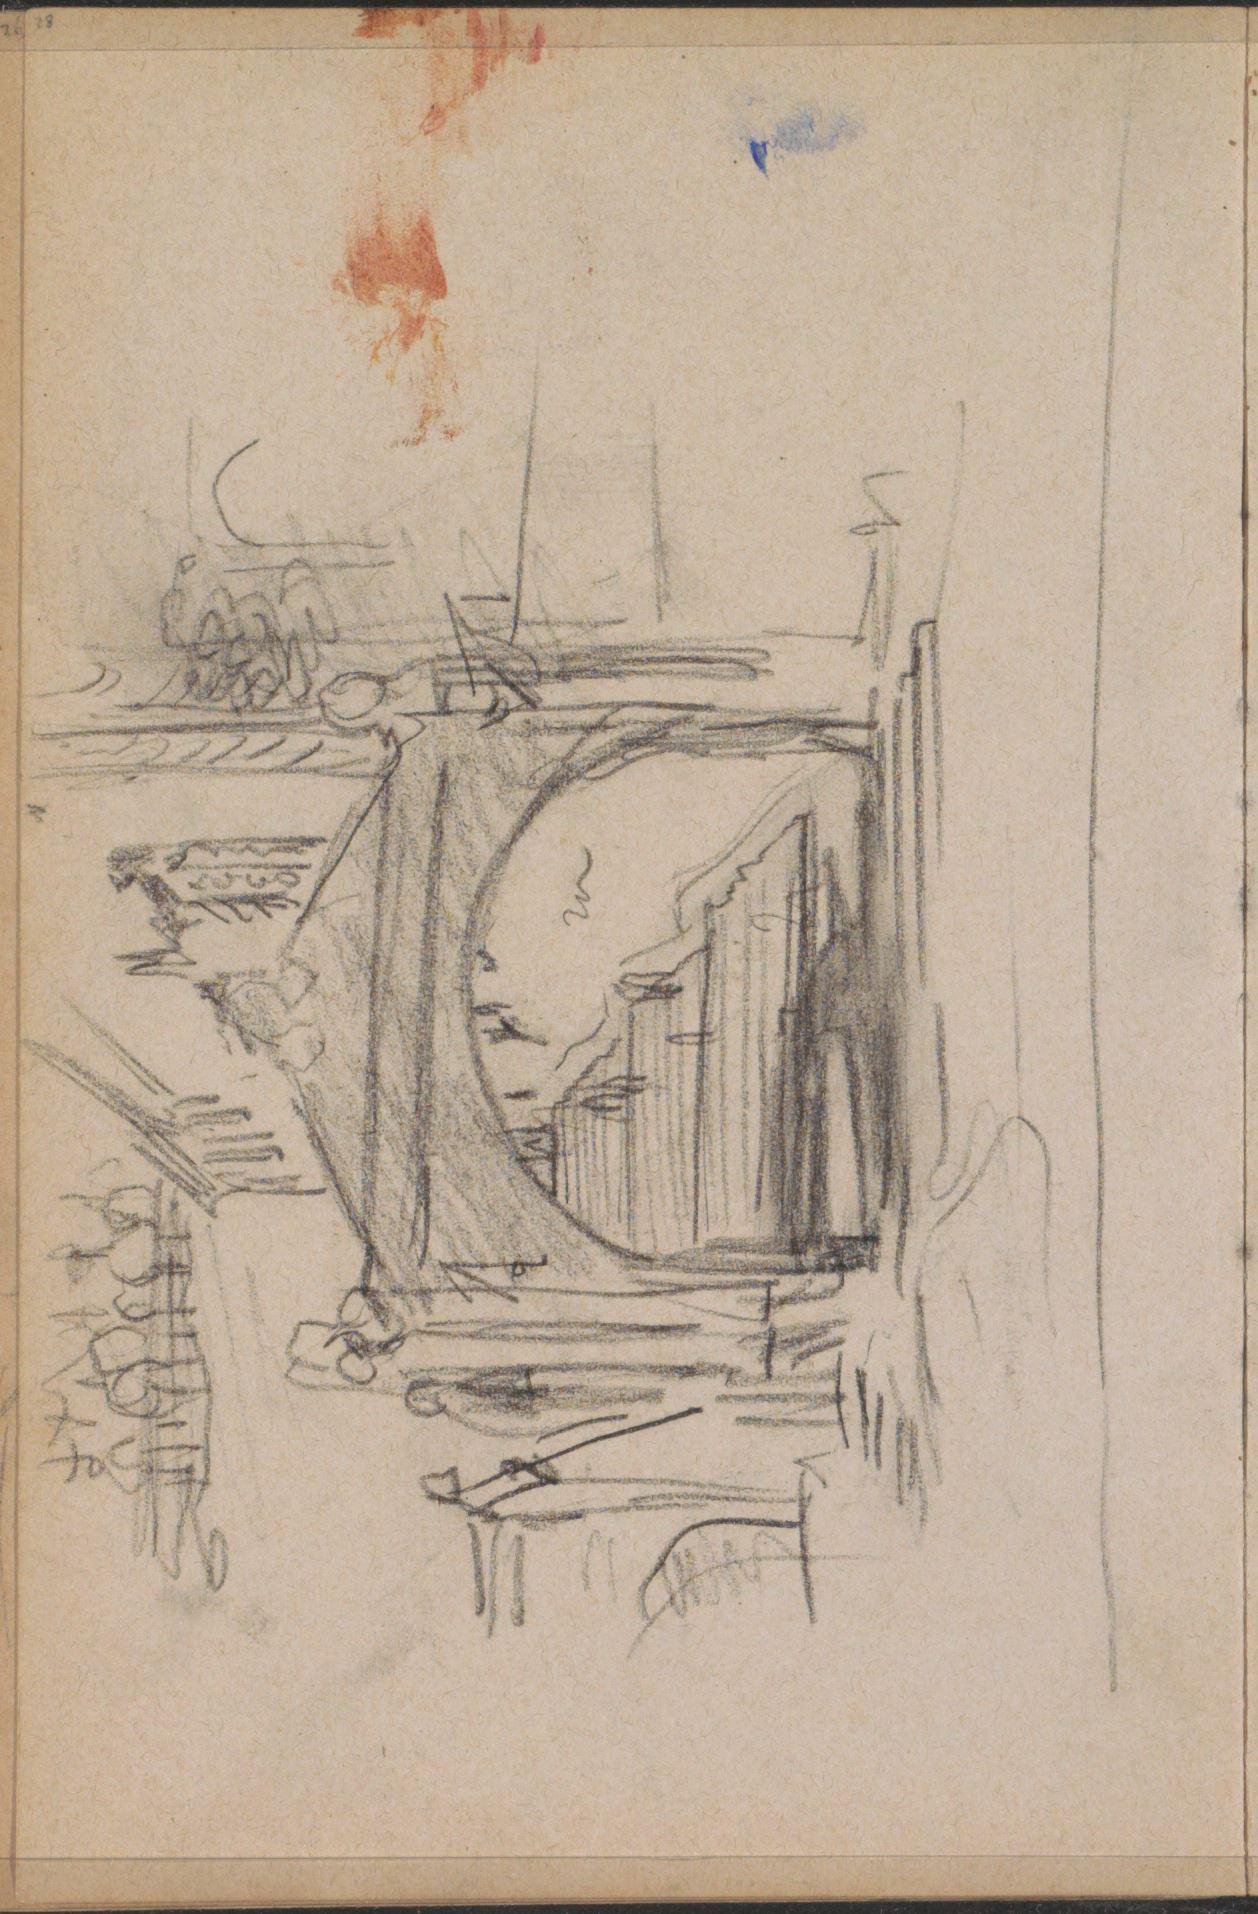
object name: sketchbook leaf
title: Trap naar de Rode Veranda van het Granovitaya Palata te Moskou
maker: marius bauer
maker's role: draughtsman, print maker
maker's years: 1867-1932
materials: chalk, paper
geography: moscow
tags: flight of steps, arch, archivolt ~ architecture, palace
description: De trap en veranda maakten deel uit van de route van de processie voor tsaar Nicolaas II. Op de achtergrond torens van het Kremlin. Pagina 28 uit een schetsboek met 54 bladen.